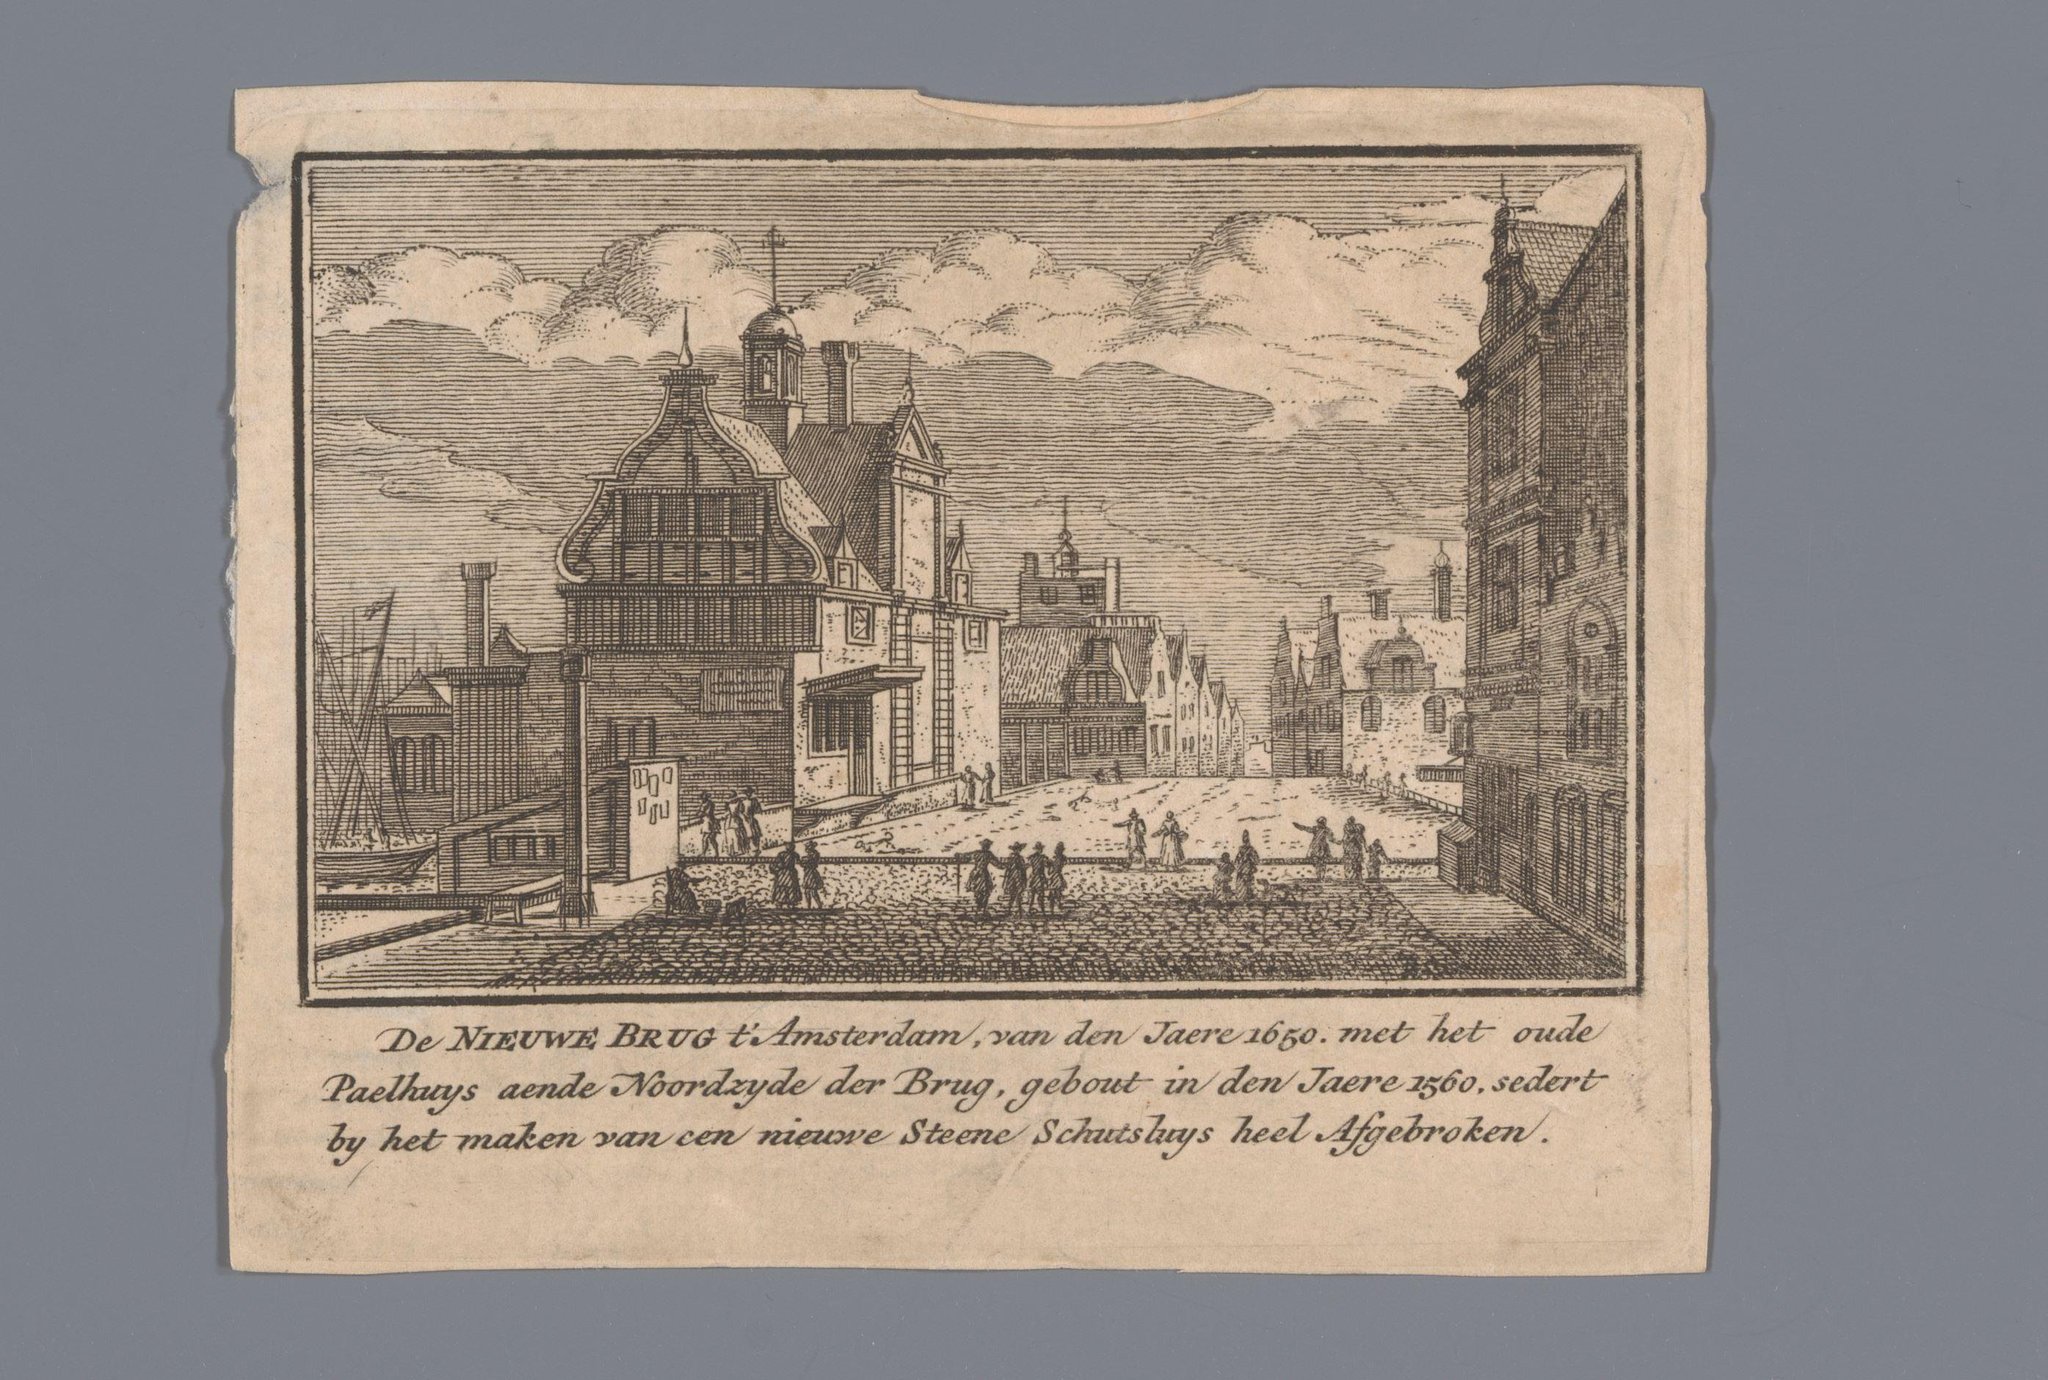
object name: book illustration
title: De Nieuwe brug t'Amsterdam, van den jaere 1650 (...)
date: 1726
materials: paper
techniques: engraving, etching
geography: amsterdam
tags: prospect of city, town panorama, silhouette of city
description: Prent uit: Rademaker, Abraham. Versameling van 100 Nederlantse outheden en gesigten (...). Amsterdam: Isaac Greve, [ca. 1726]. Deze afbeelding is een kopie van de versie met eenregelig onderschrift, uit: Rademaker, Abraham. Kabinet van Nederlandsche outheden en gezichten (...). Amsterdam: Willem Barents, 1725, plaat 18.